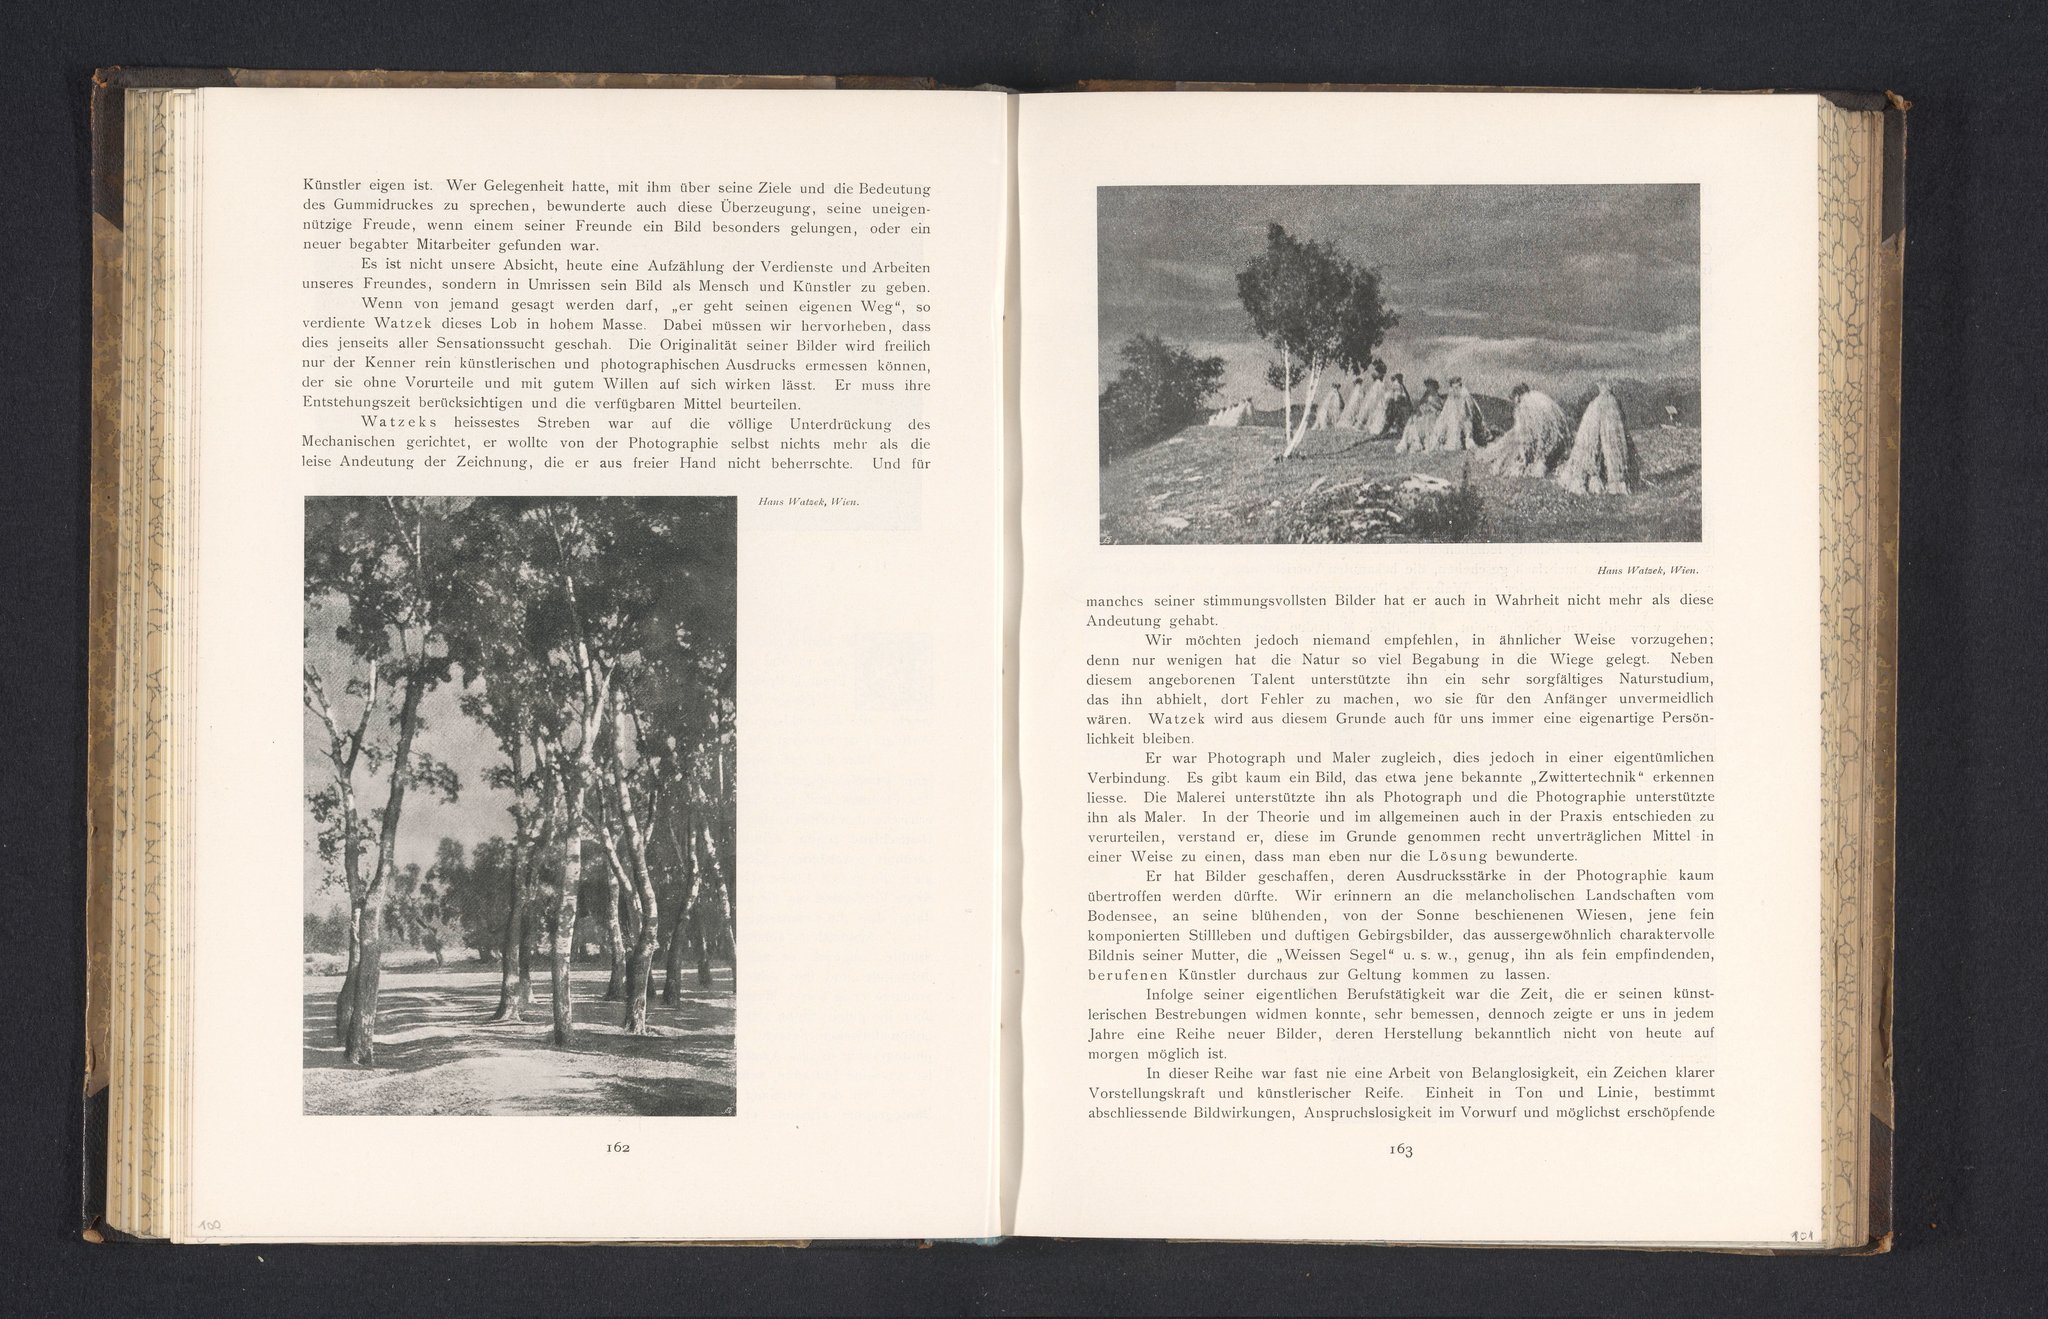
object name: photomechanical print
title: Bomen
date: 1898-1903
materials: paper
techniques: autotype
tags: trees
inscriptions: monogram: ‘AG’